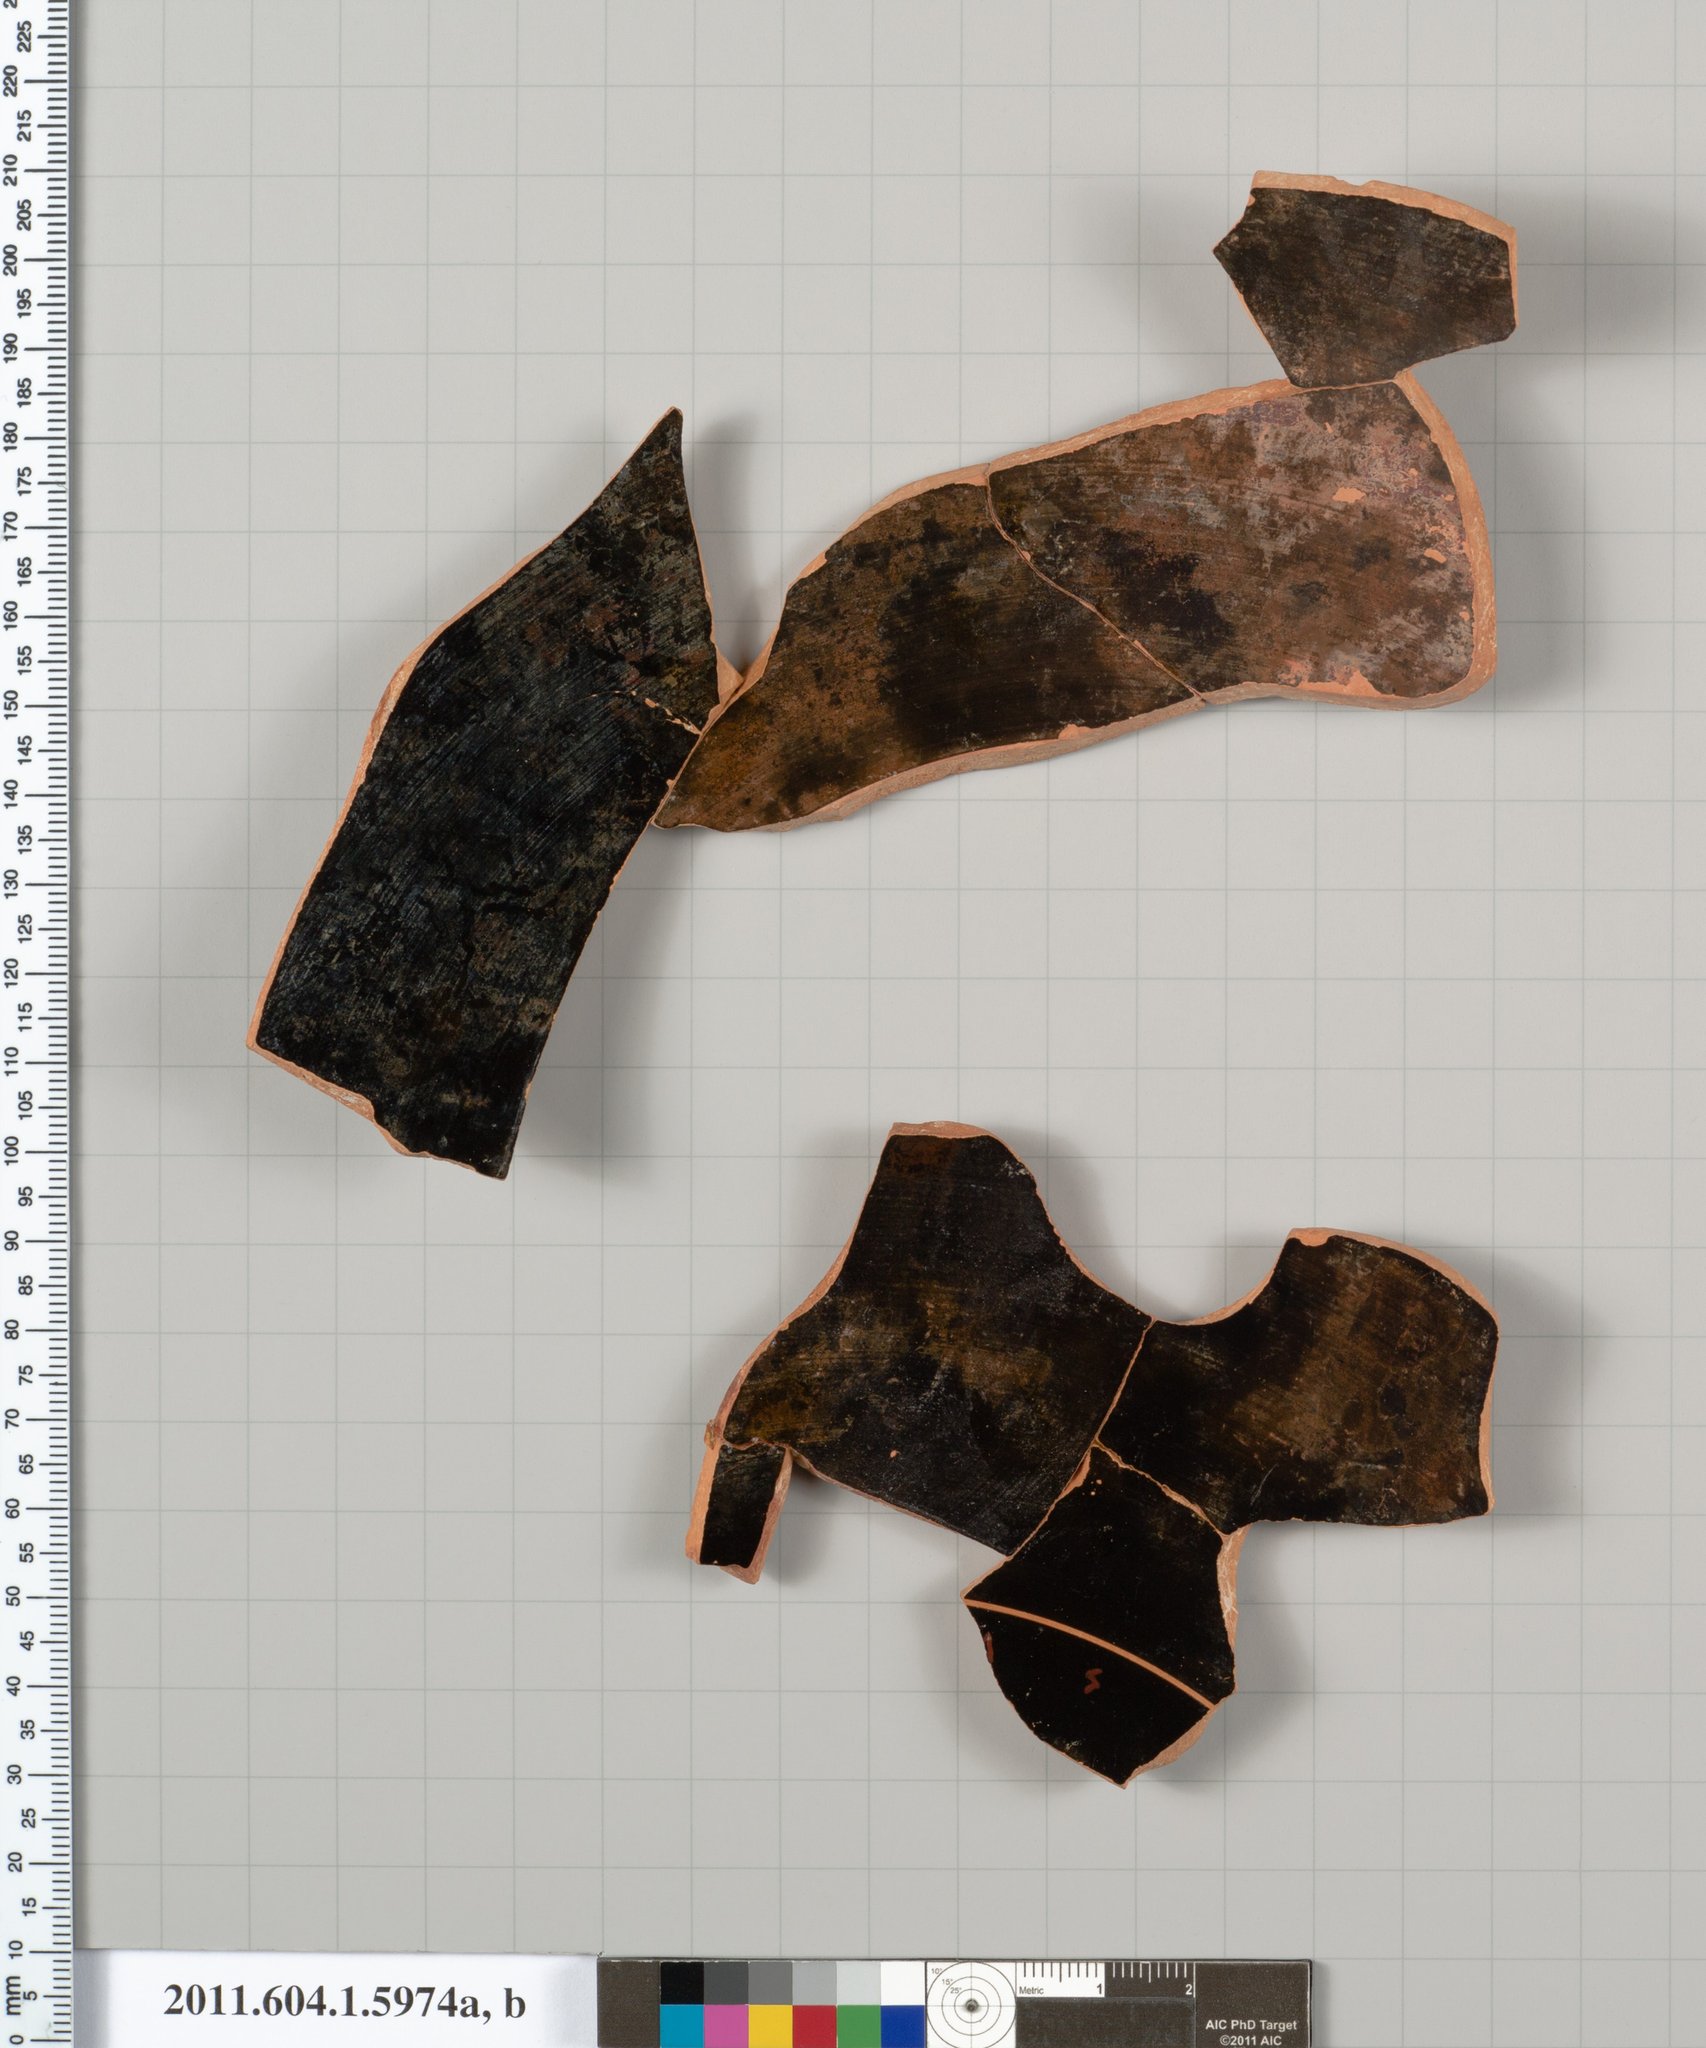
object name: kylix fragment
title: Terracotta fragments of a kylix (drinking cup)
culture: greek, attic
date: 433-567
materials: terracotta